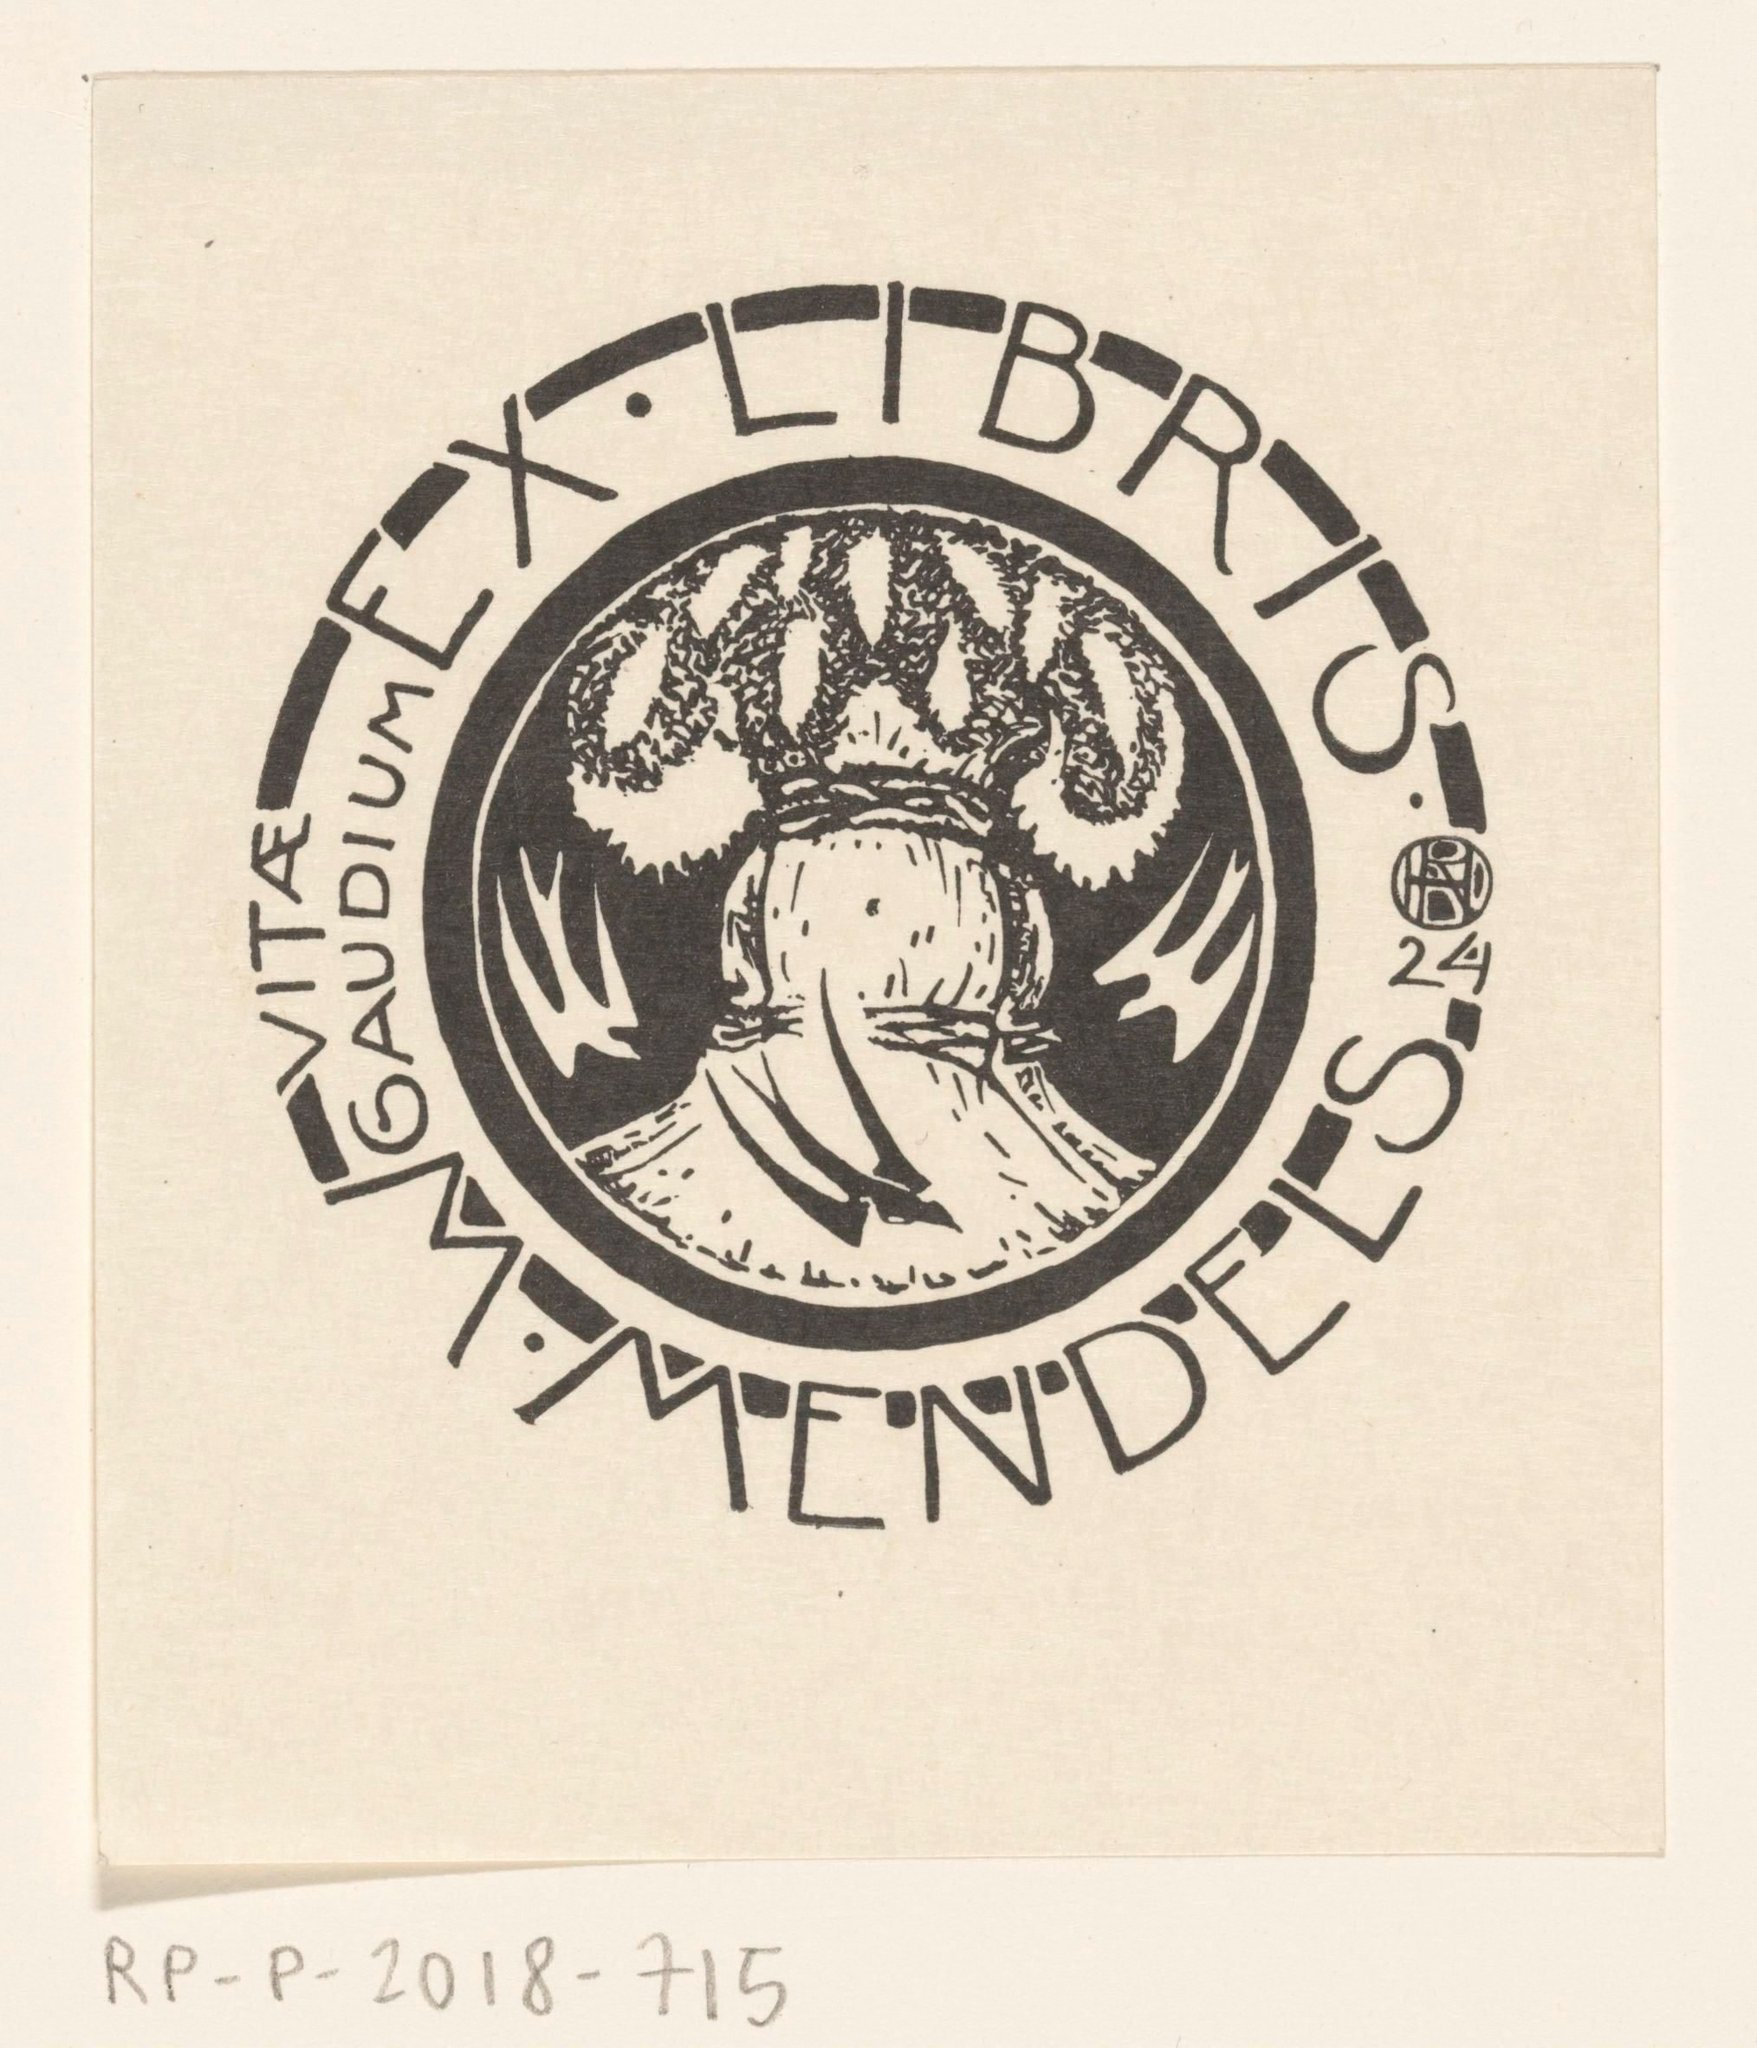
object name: print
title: Vitae Gaudium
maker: richard nicolaüs roland holst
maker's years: 1868-1938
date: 1924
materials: paper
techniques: line block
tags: song-birds: swallow, sheaf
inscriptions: number: ‘10’